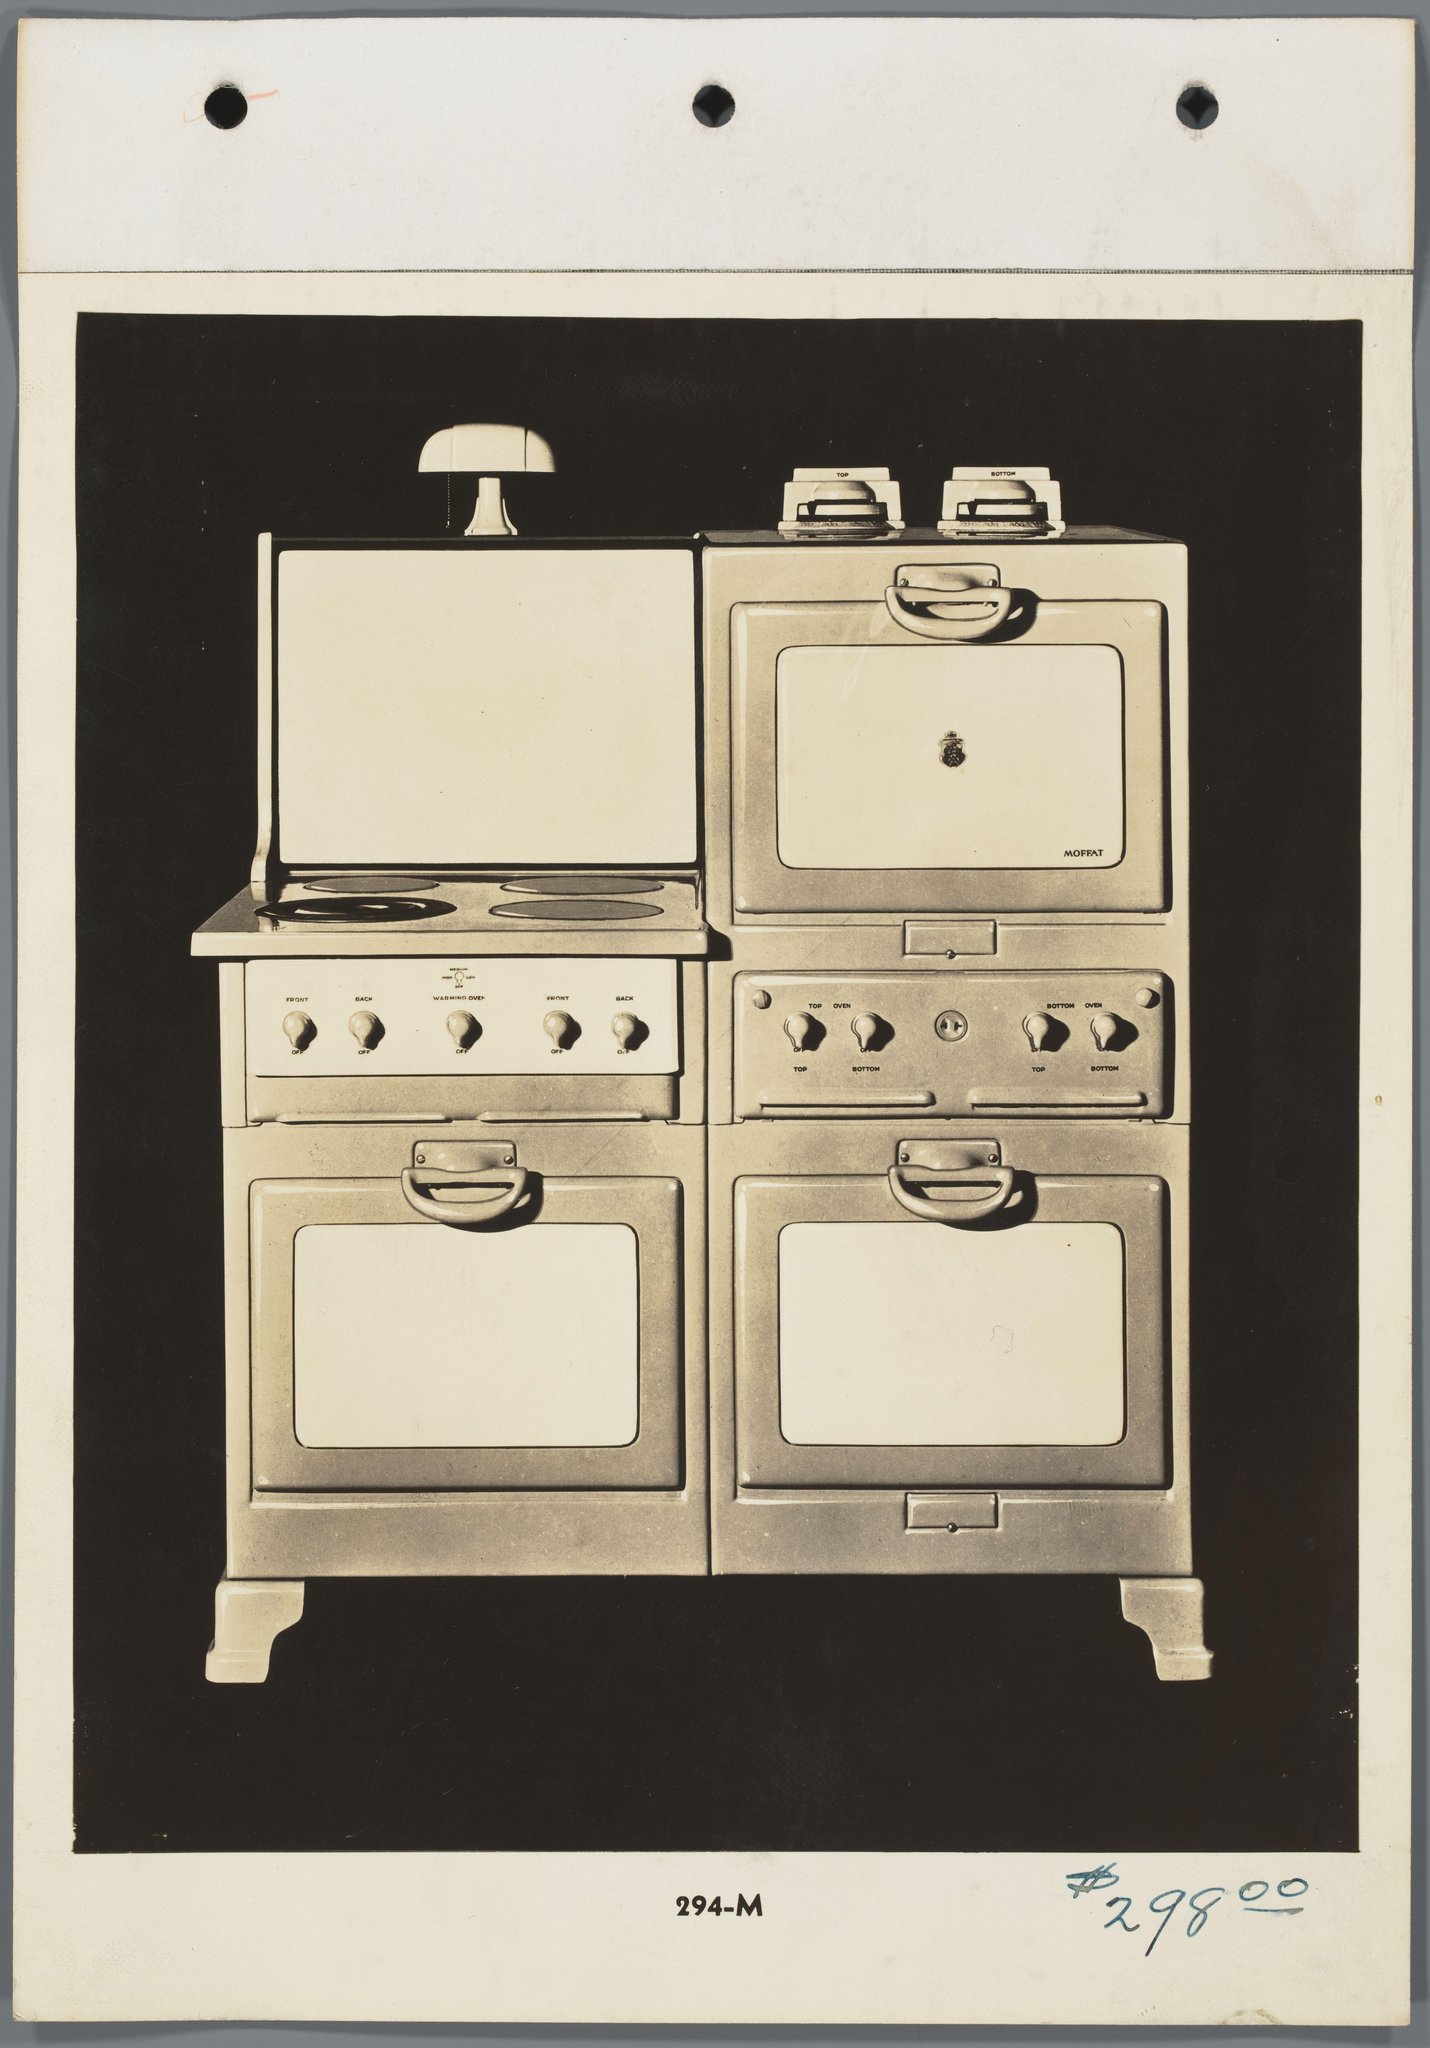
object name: photograph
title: Foto van Moffat ovens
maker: Anonymous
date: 1935-1940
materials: paper, photographic support, textile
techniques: gelatin silver print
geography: canada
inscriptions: inscription: ‘$ 29800’, inscription: ‘294-M’